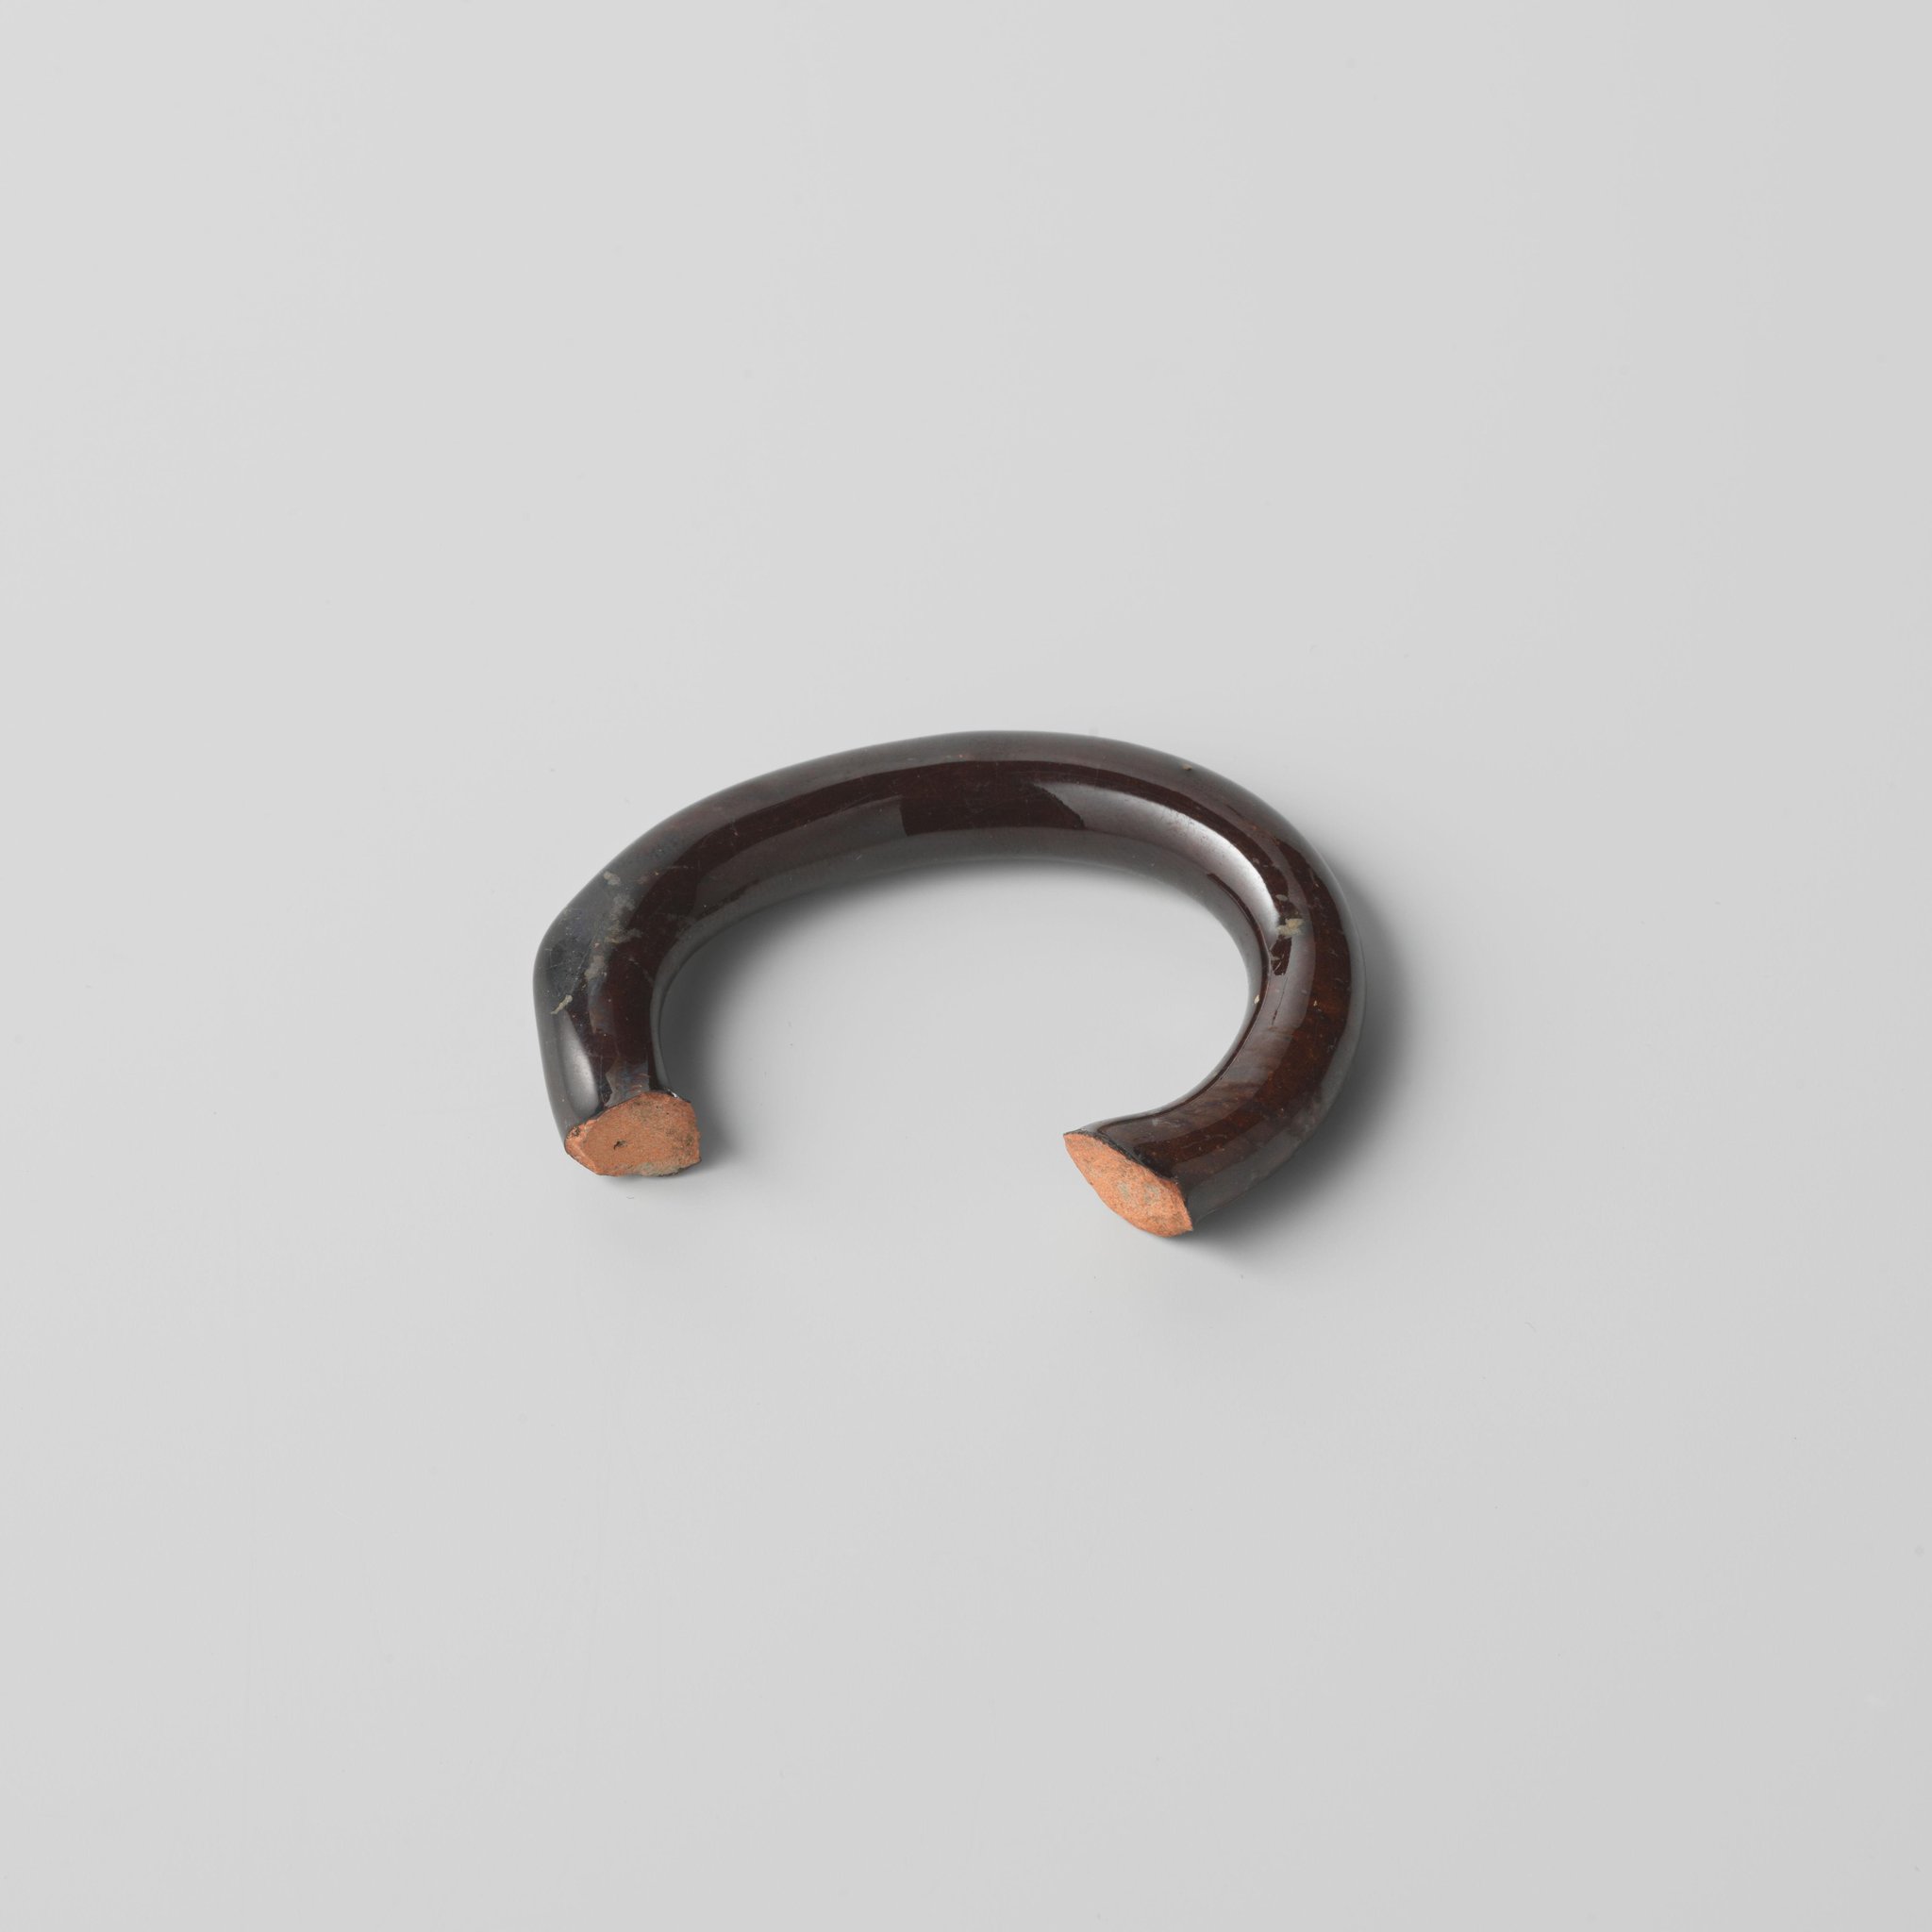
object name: fragment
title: Oor van een theepot (De Caluwe bakafval)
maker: jacobus de caluwe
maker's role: plateelbakkerij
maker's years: -1730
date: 1700-1725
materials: earthenware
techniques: firing, vitrification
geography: delft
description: Toegeschreven aan Jacobus de Caluwe, omdat dit voorwerp samen met gemerkte stukken (‘Jacobus De Caluwe’ en rennend hert) gevonden is op de plaats waar zich De Caluwes tweede werkplaats bevond. Er is een duidelijke stilistische overeenkomst tussen de gemerkte en niet gemerkte voorwerpen uit deze archeologische vondst.